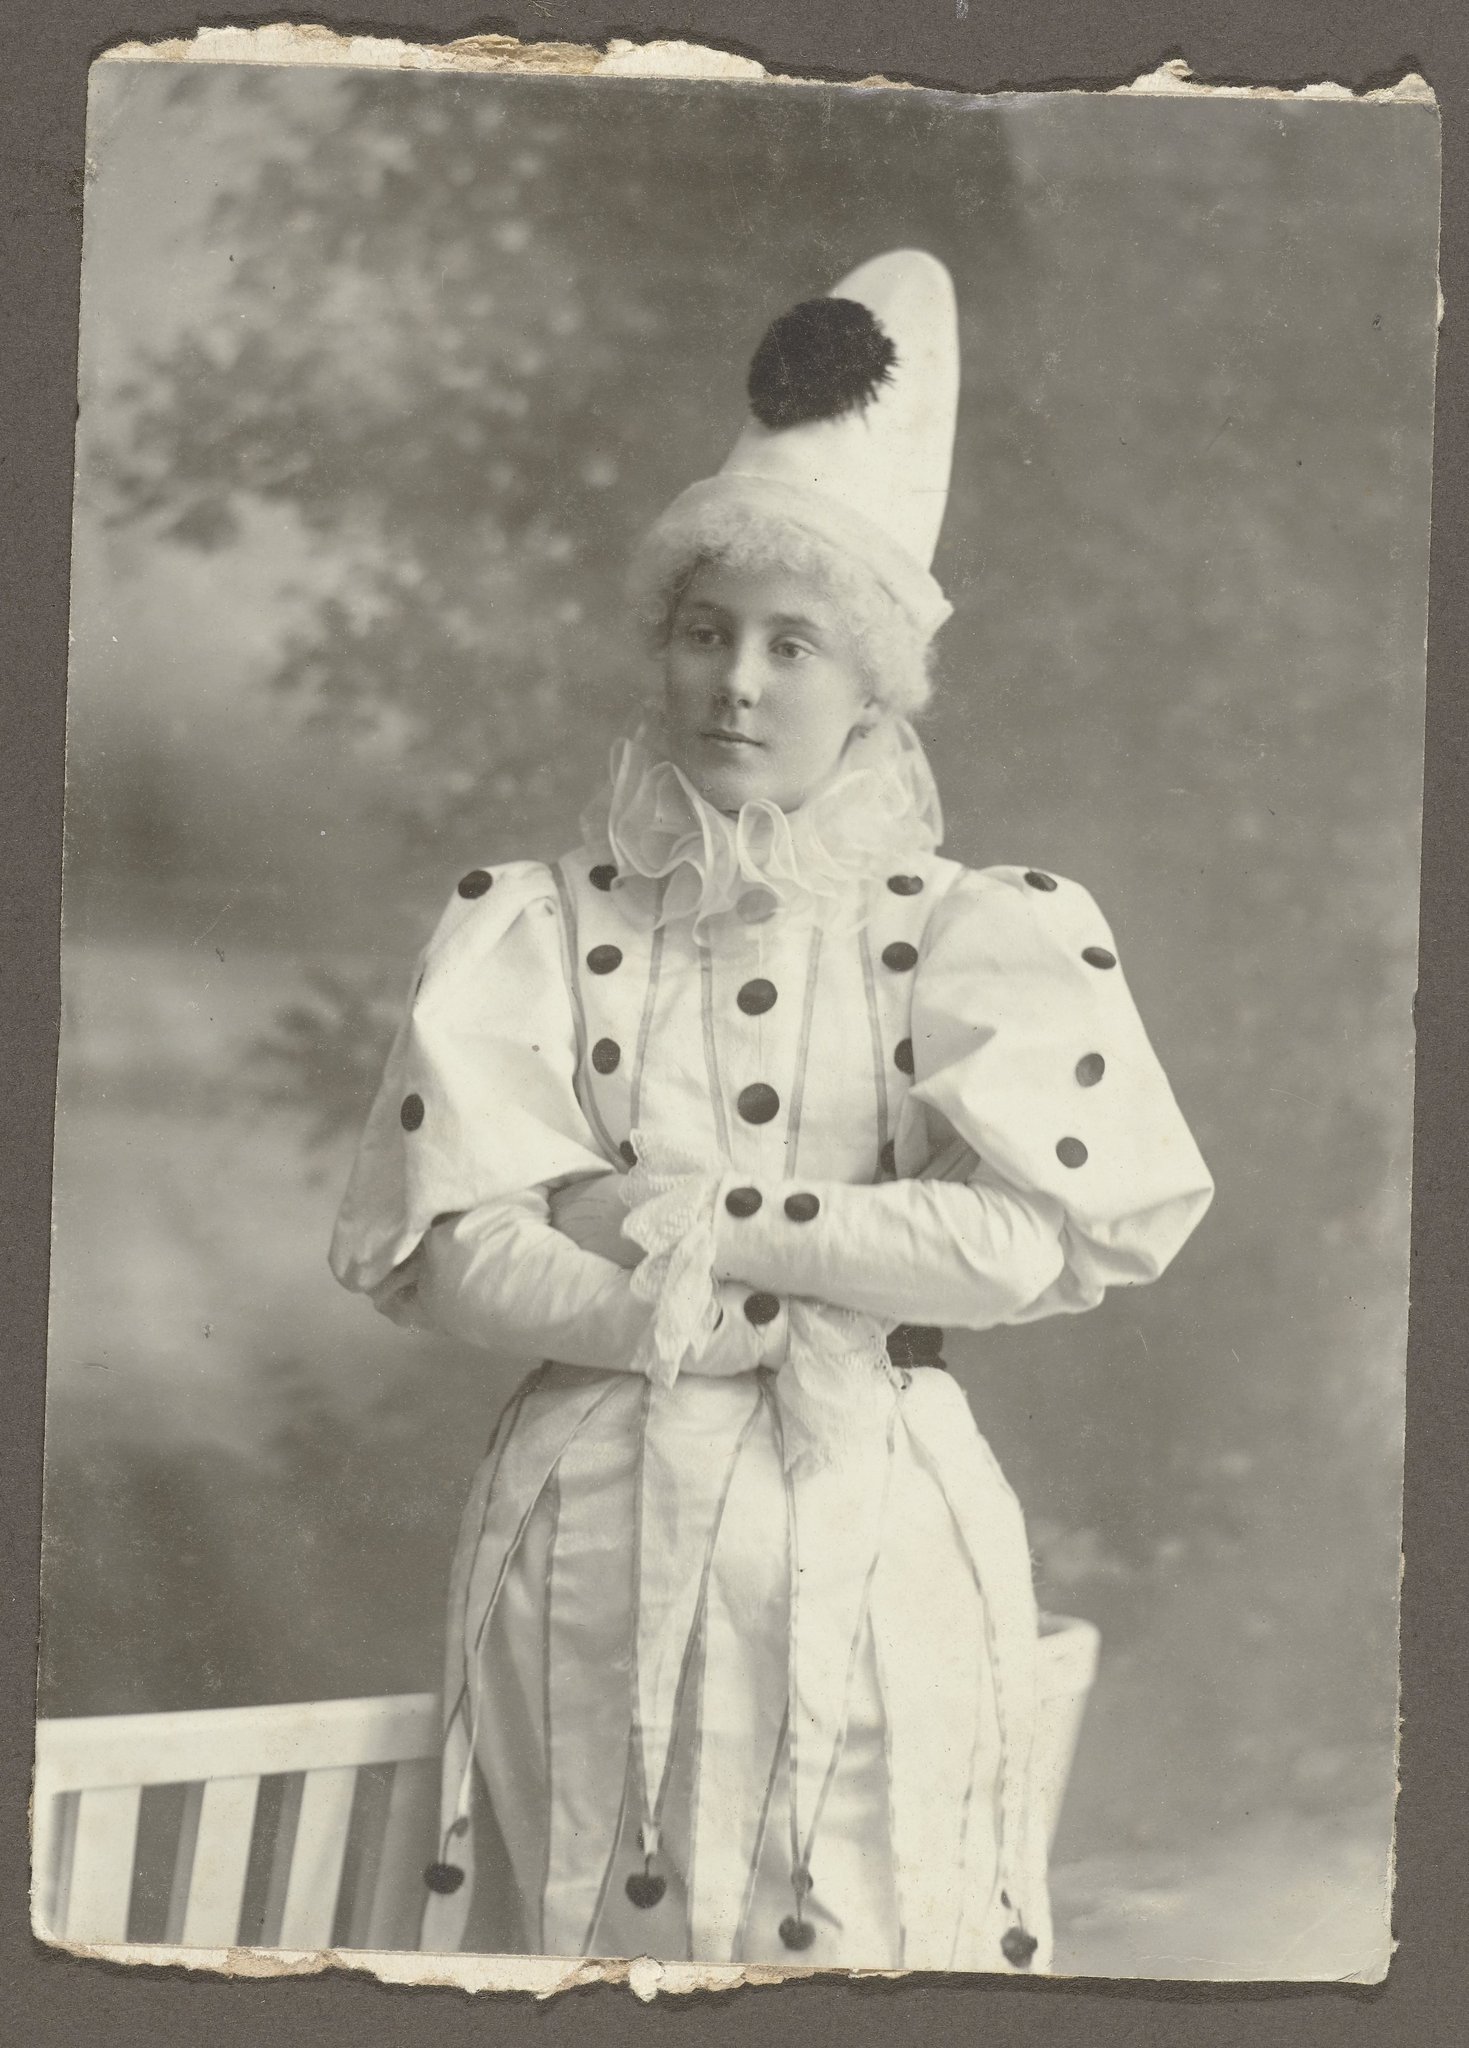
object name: album leaf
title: Portret van Tine in een kostuum met stippen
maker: cornelis johannes lodewicus vermeulen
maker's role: fotograaf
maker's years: 1861-1936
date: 1900-1925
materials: paper, cardboard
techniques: gelatin silver print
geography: amsterdam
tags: historical persons - bb - woman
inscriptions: inscription: ‘Tine’